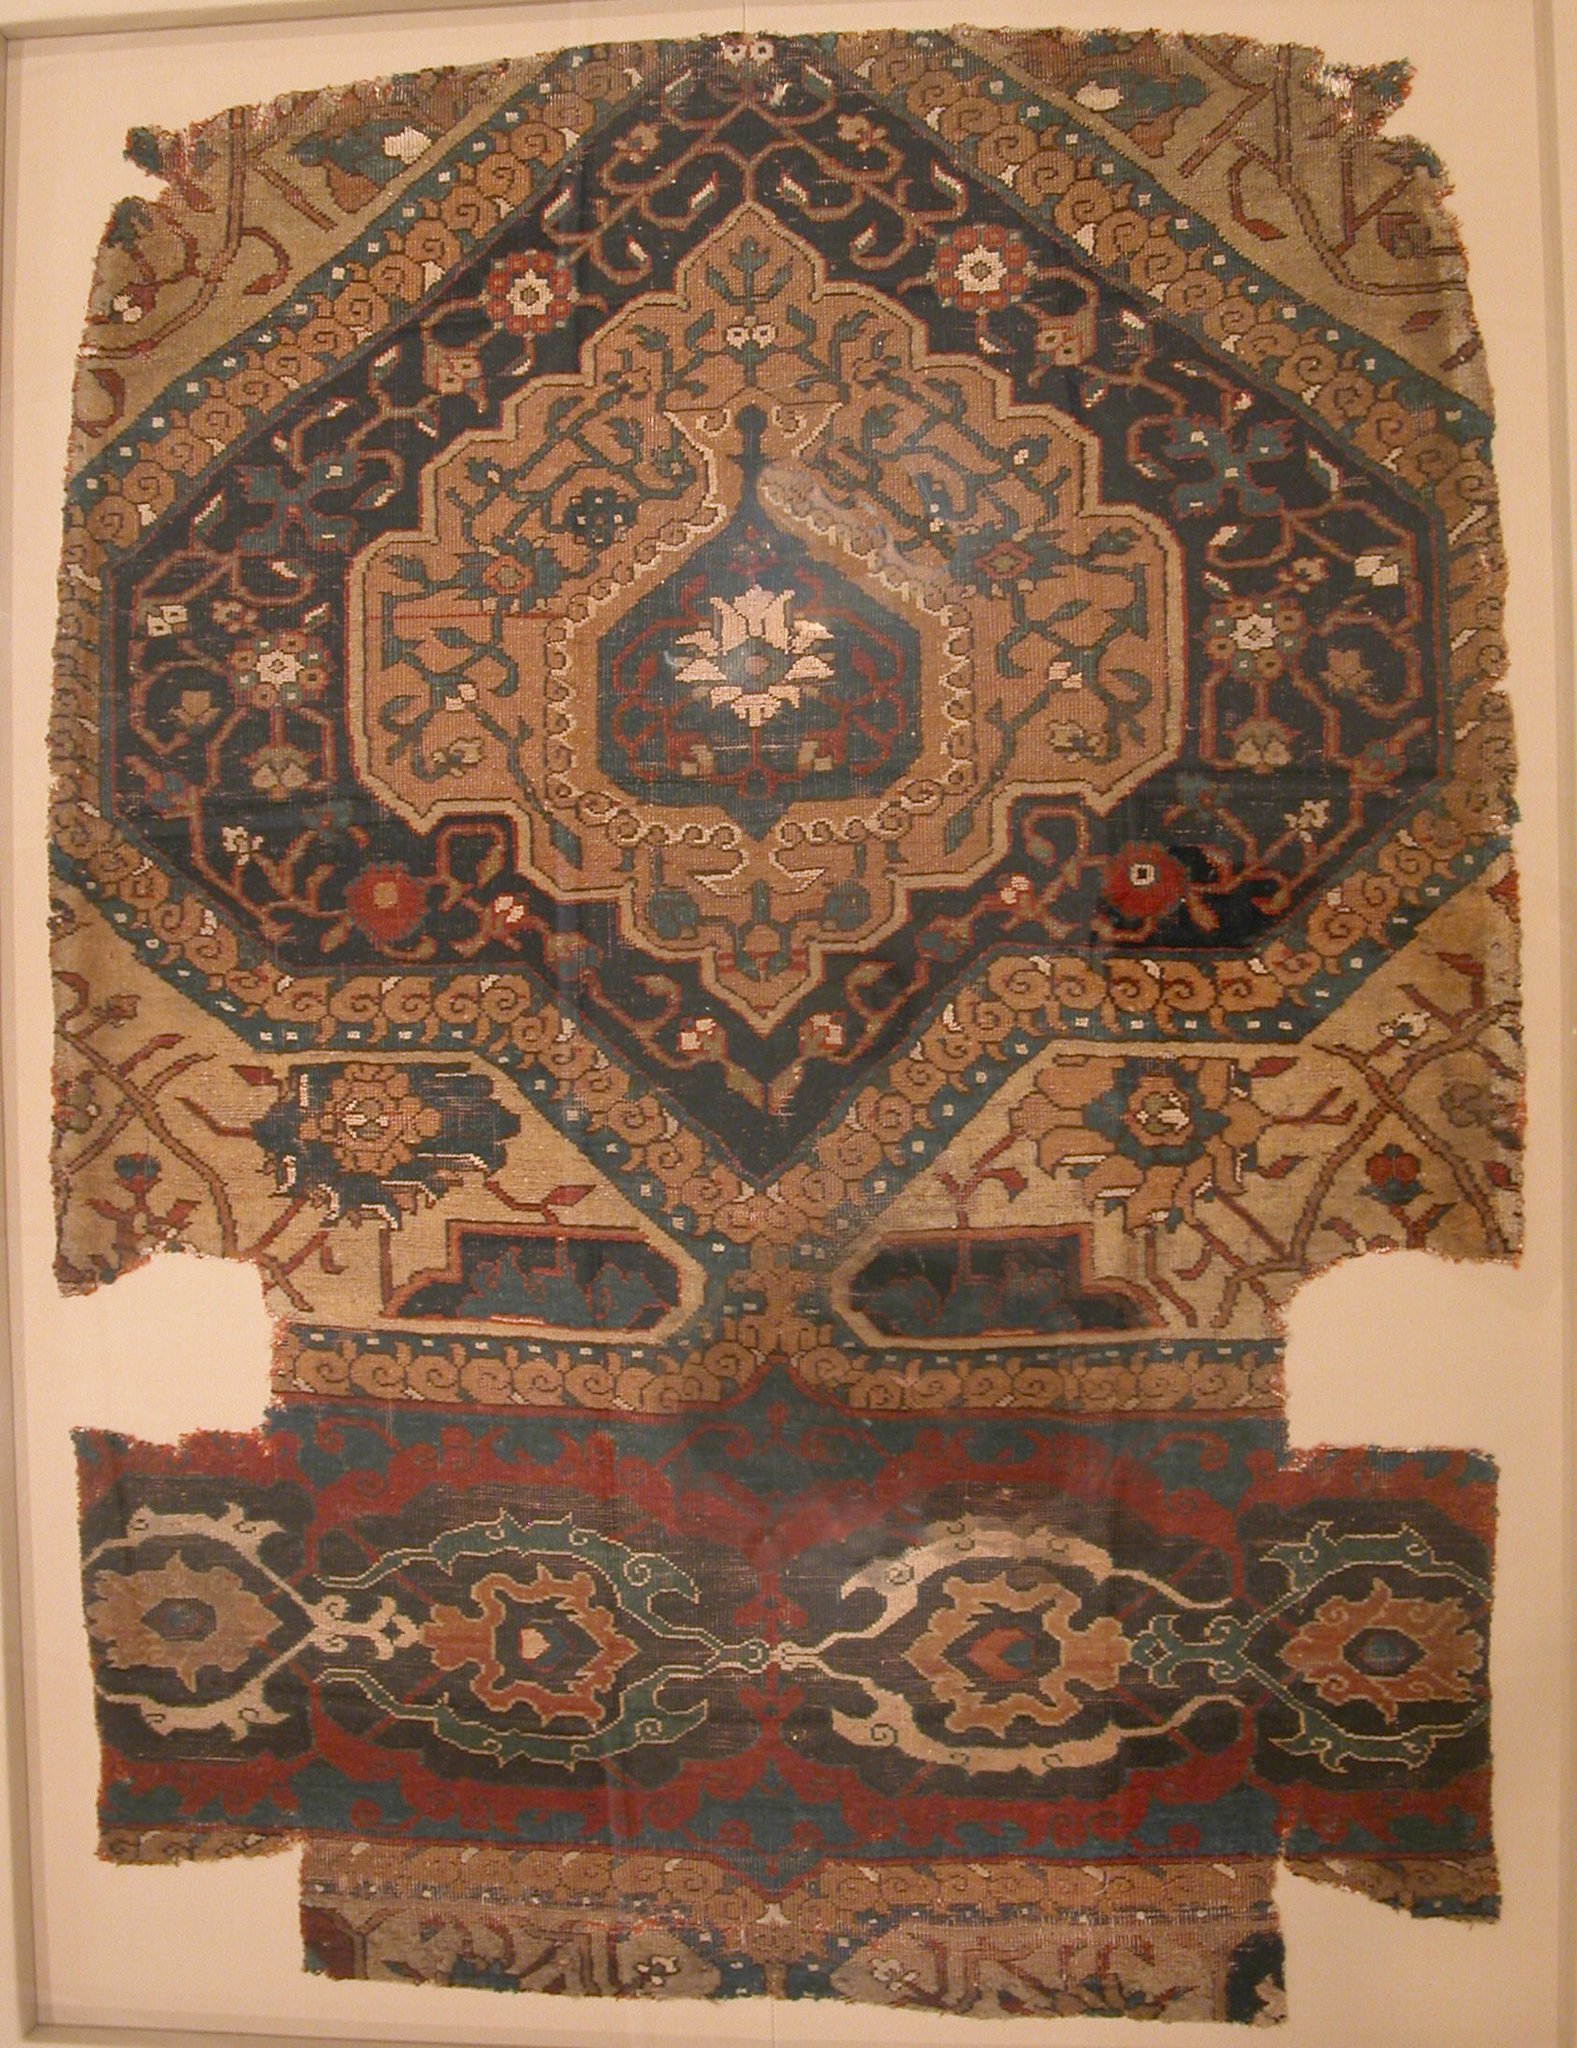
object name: carpet fragment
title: Fragment of a Northwest Persian Medallion Carpet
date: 1501-1533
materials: cotton, wool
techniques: asymmetrically knotted pile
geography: northwestern iran